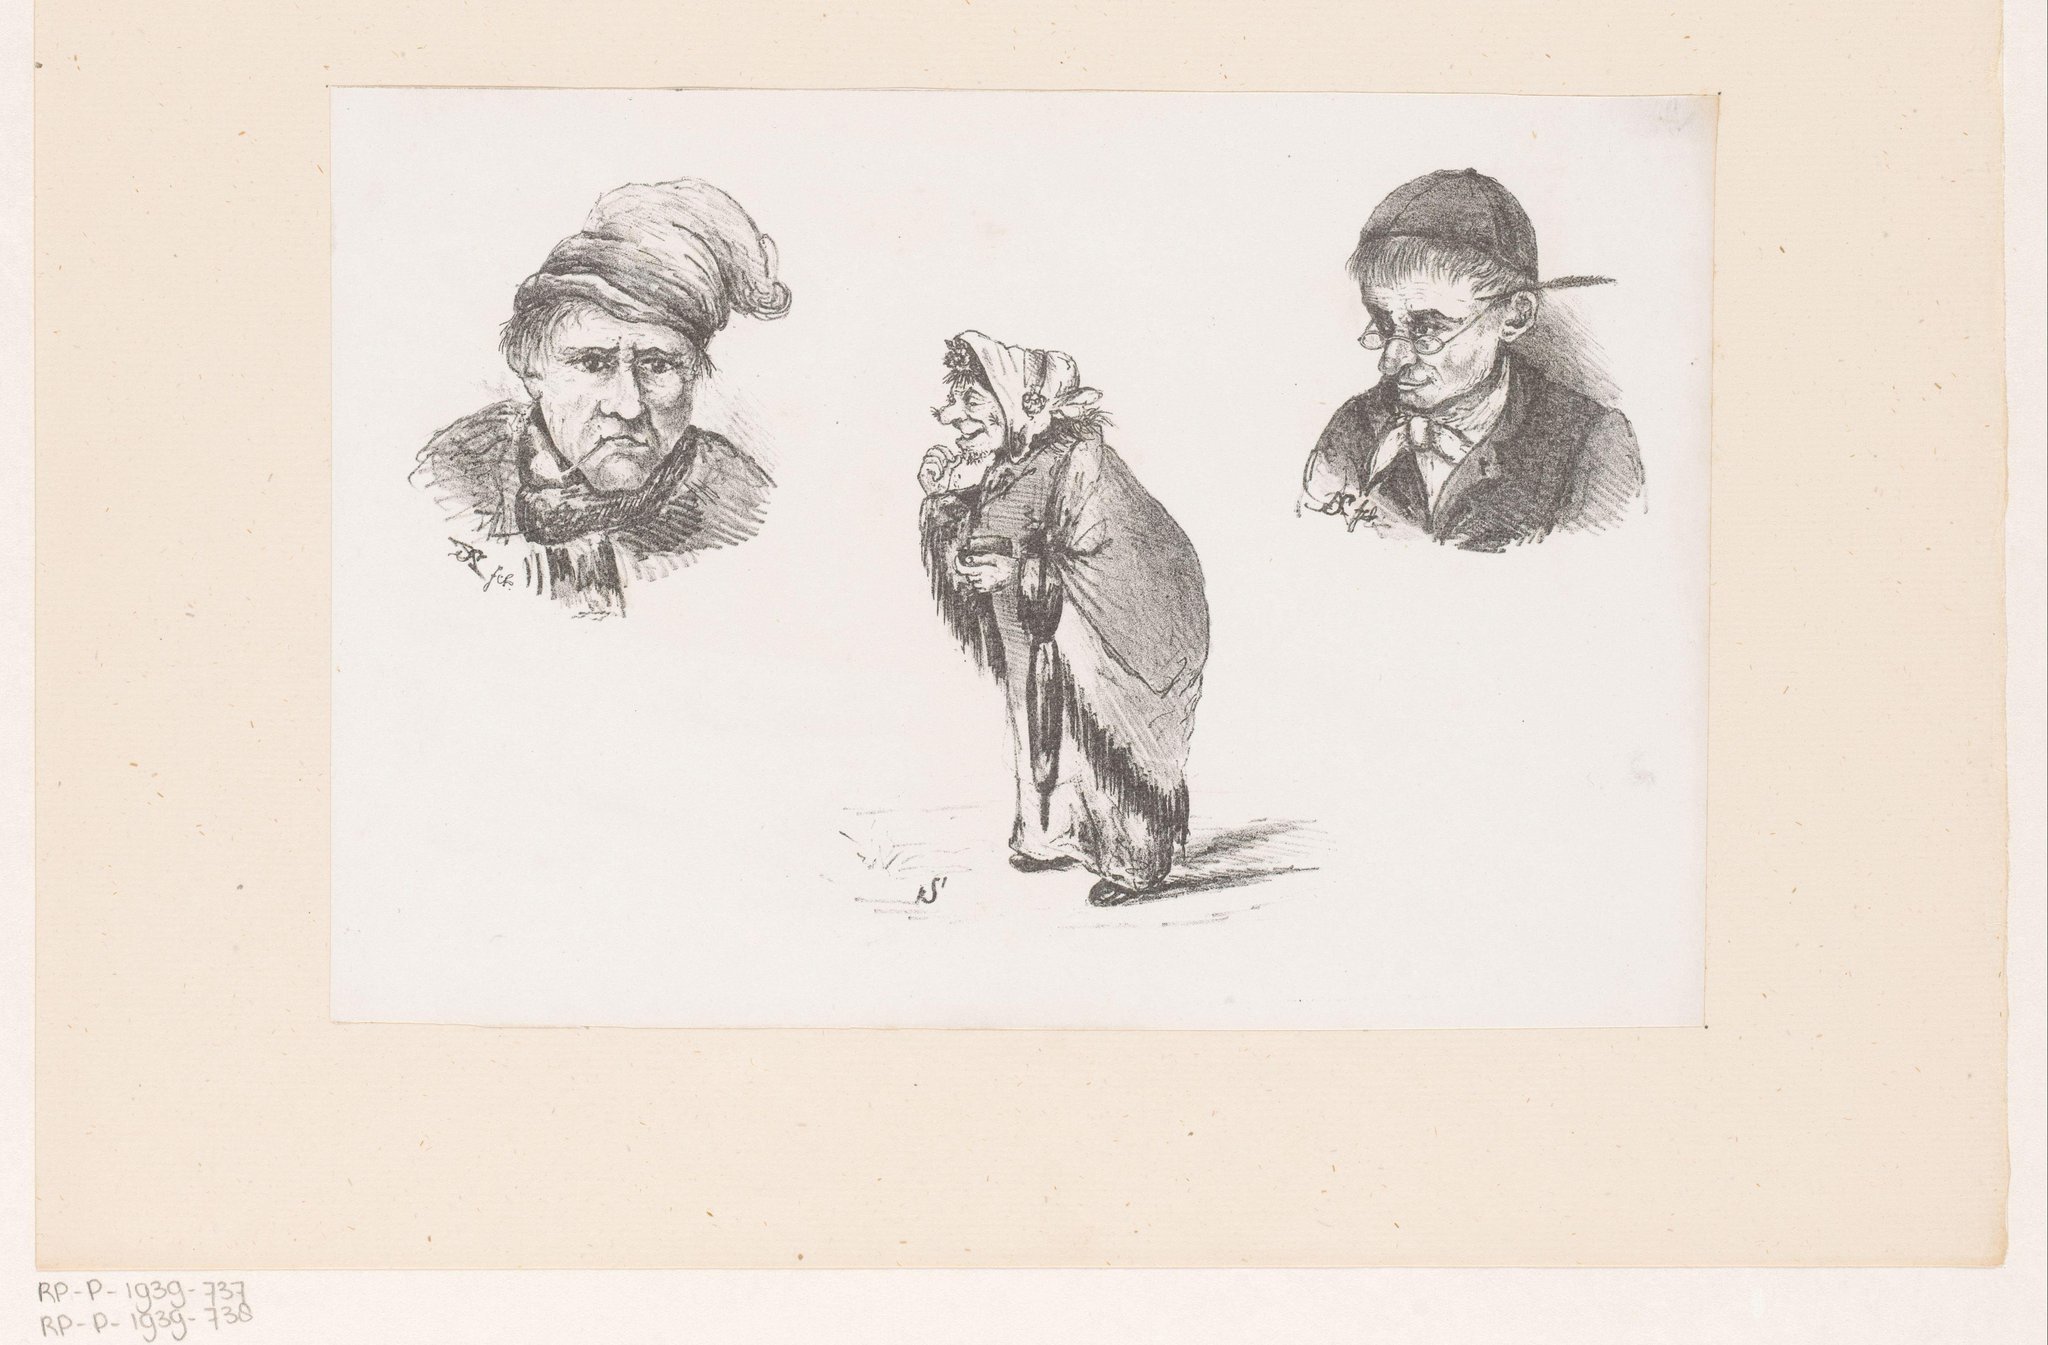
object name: print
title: Studies van twee mannen en een oude vrouw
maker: jeremias adriaan adolf schill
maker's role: print maker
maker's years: 1849-1902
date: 1864-1902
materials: paper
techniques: lithograph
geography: netherlands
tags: adult man, ugly old woman, hag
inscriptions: collector's mark: Lugt 2760, collector's mark: Lugt 2166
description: Studies van een pijprokende man met muts, een man met bril en schrijfveer achter zijn oor en een oude vrouw met paraplu ten voeten uit.